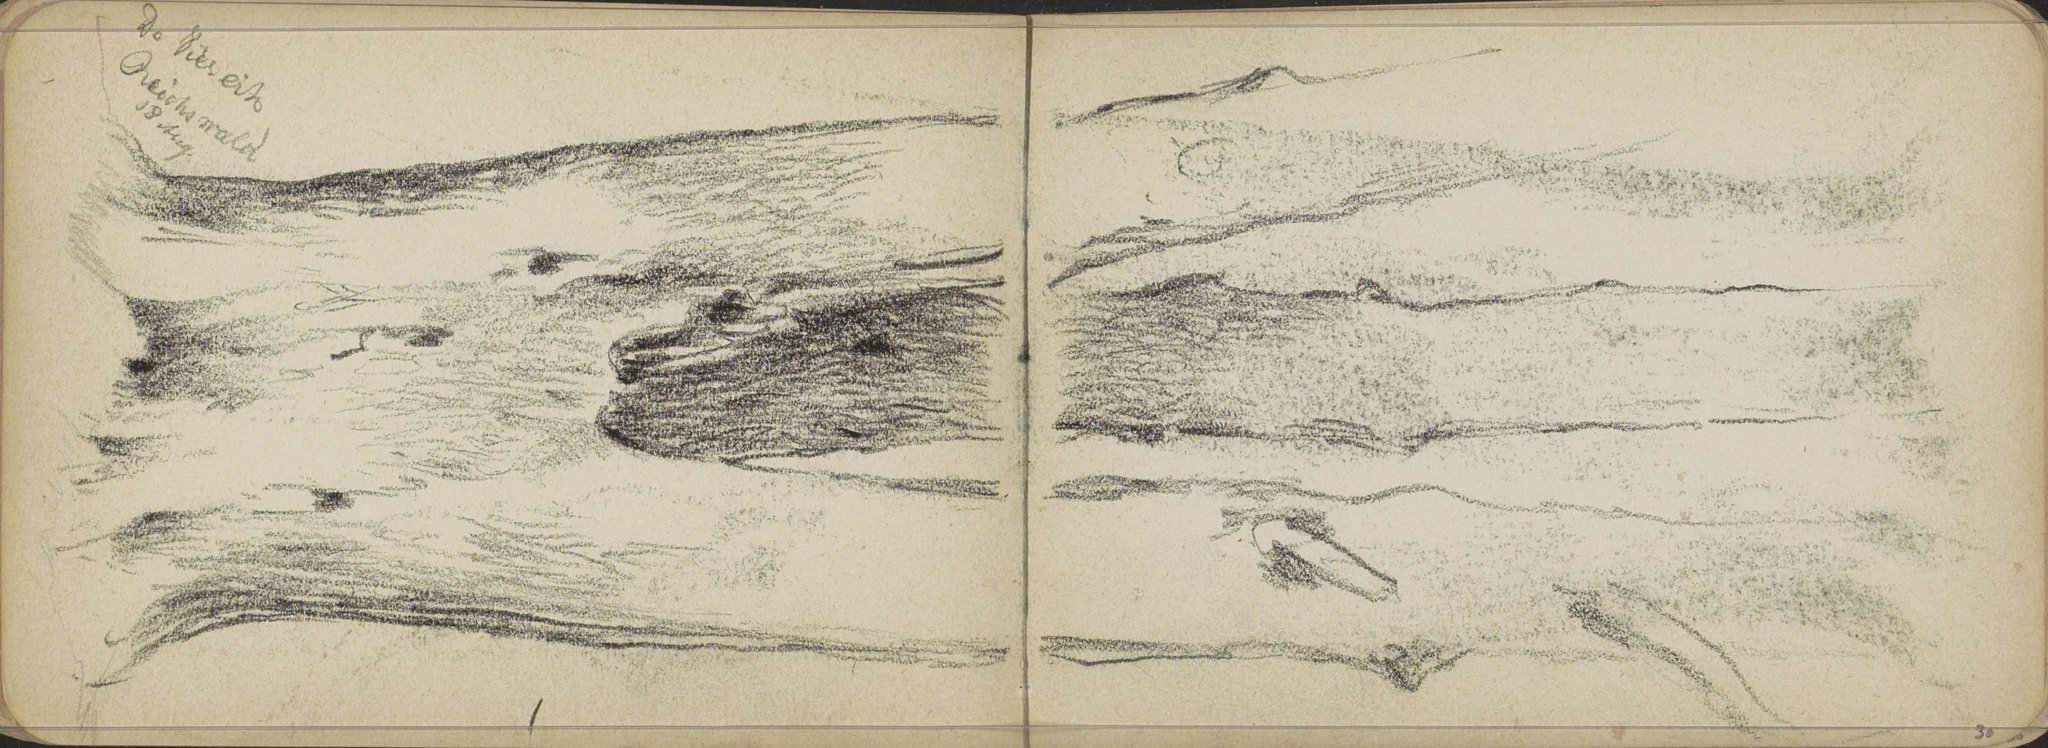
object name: sketchbook leaf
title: Stam van een eik in het Reichswald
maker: willem cornelis rip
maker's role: draughtsman, painter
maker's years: 1856-1922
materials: chalk, paper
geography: reichswald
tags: trees: oak (+ stem, trunk)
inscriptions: date and inscription: ‘De Vier eik/ Reichswald/ 18 Aug’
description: Blad 29 verso en 30 recto uit een schetsboek met 44 bladen.